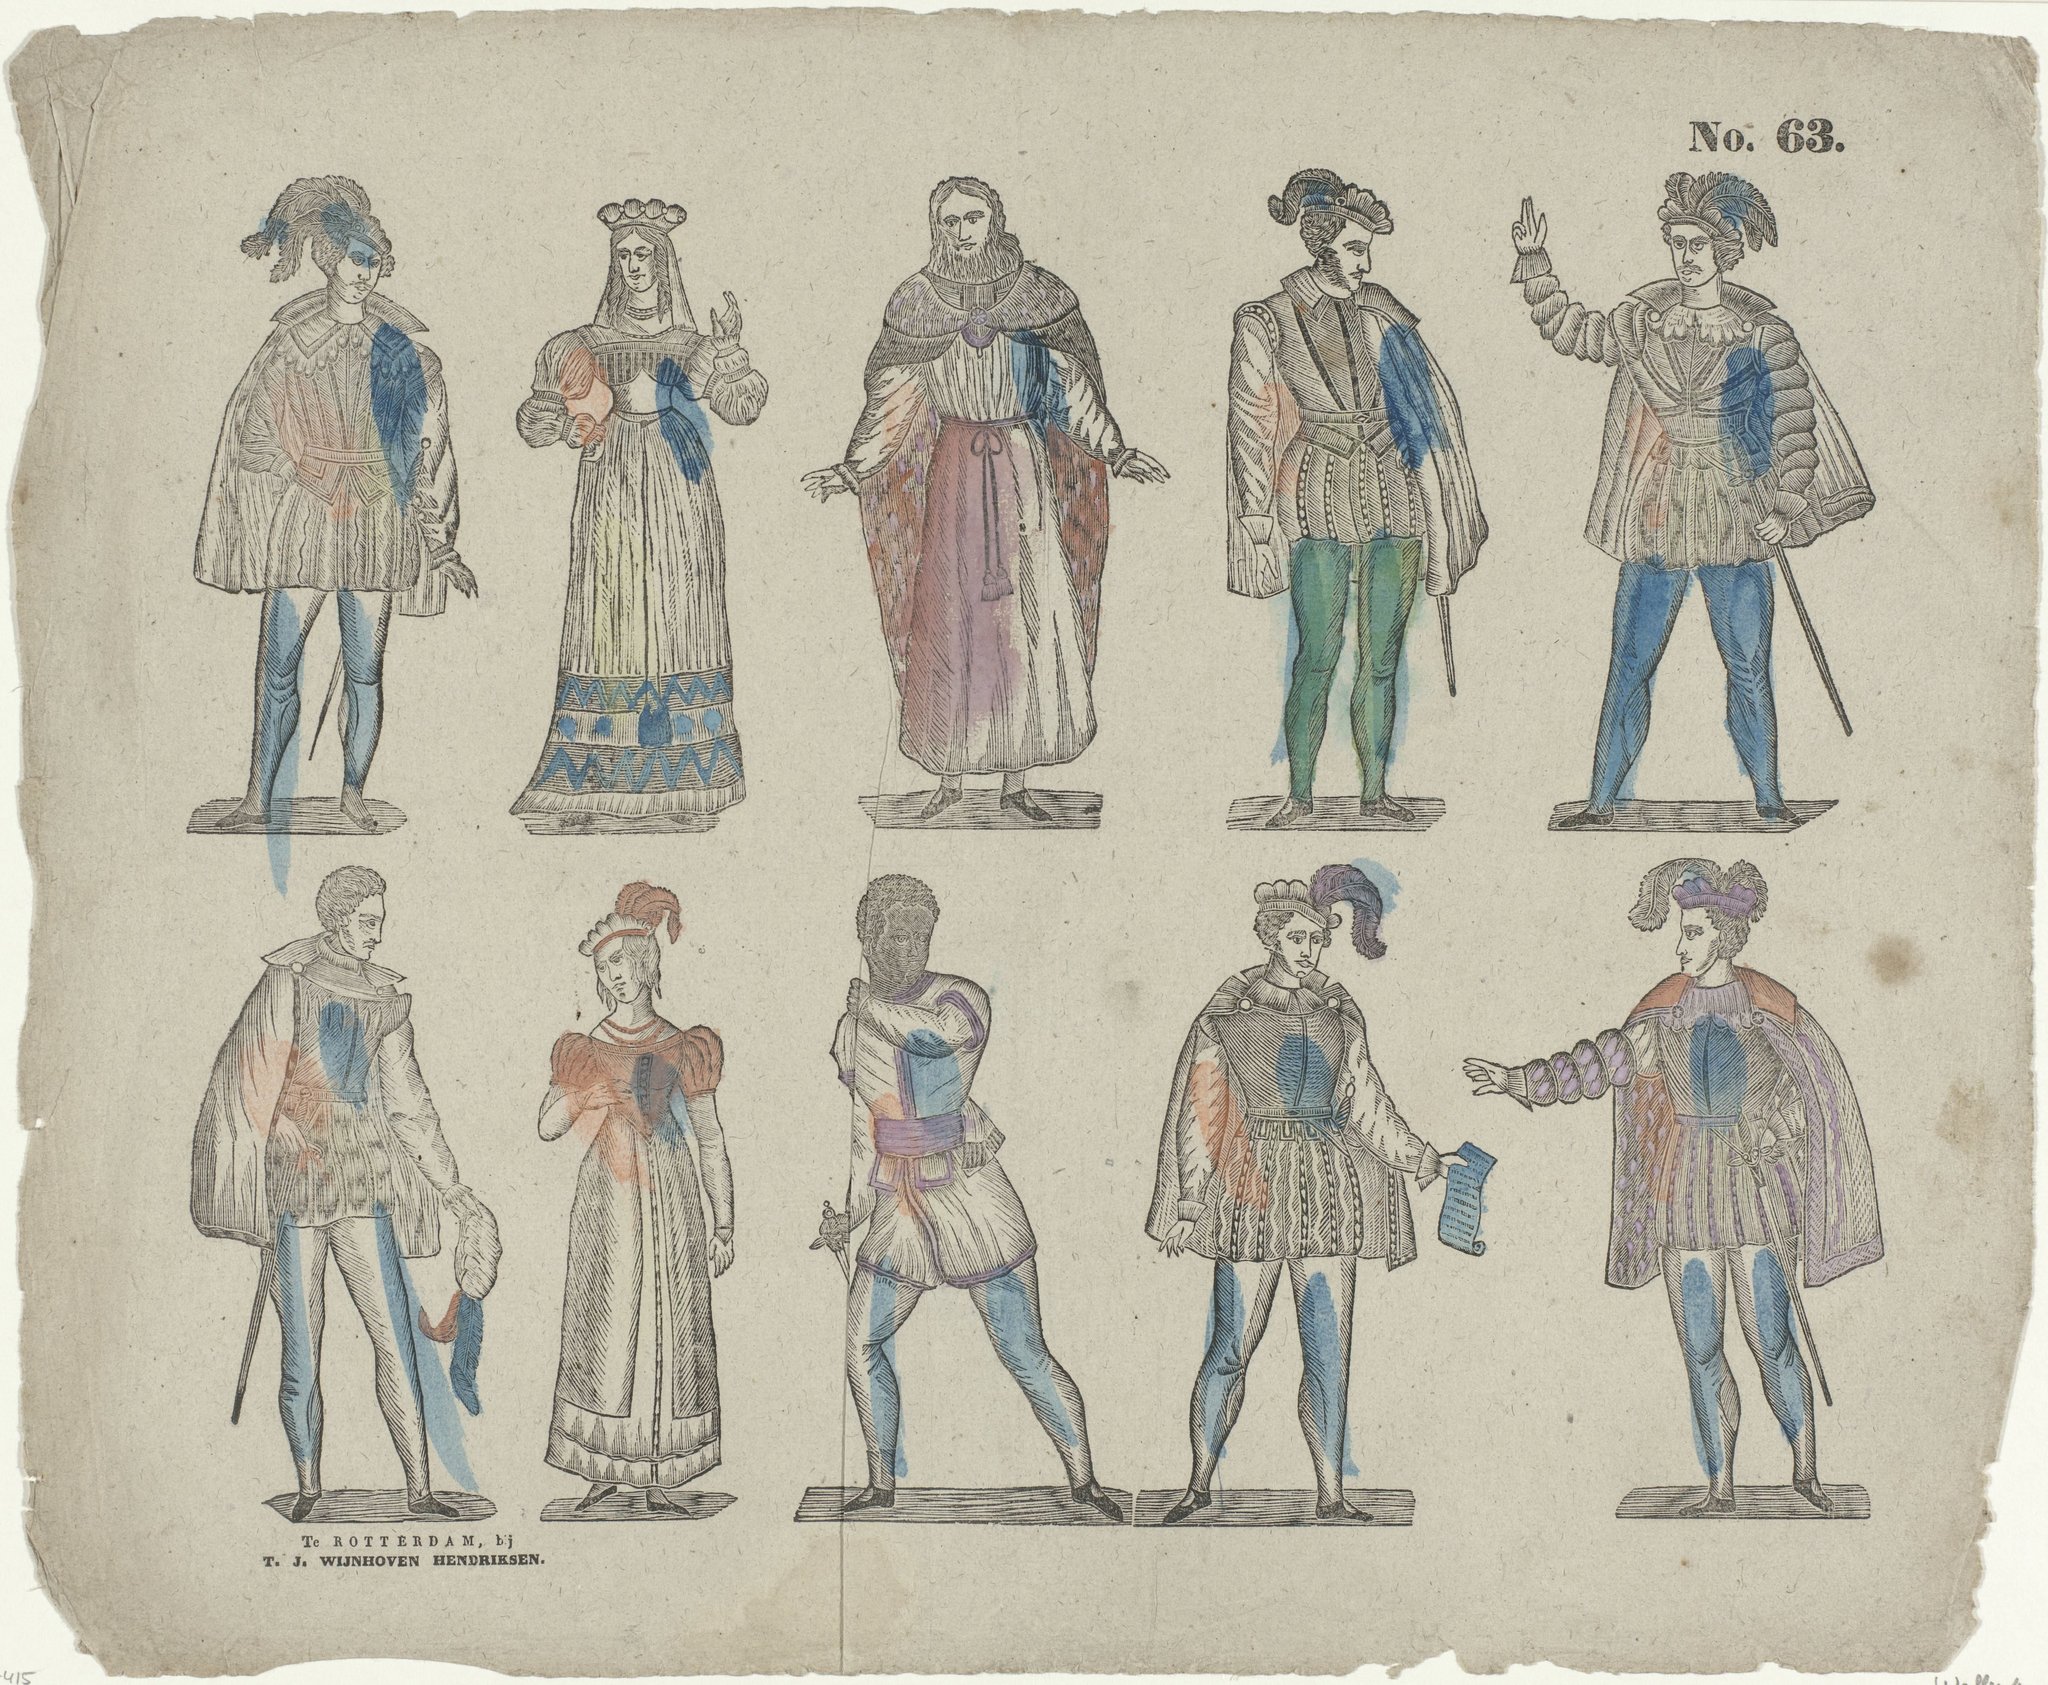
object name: popular print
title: Tien figuren in historische kledij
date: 1832-1850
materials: paper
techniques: colour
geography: rotterdam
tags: historical costume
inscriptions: collector's mark: Lugt 2760, collector's mark: Lugt 2228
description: Blad met 10 voorstellingen van mannen en vrouwen in historische kledij. Genummerd rechtsboven: No. 63.